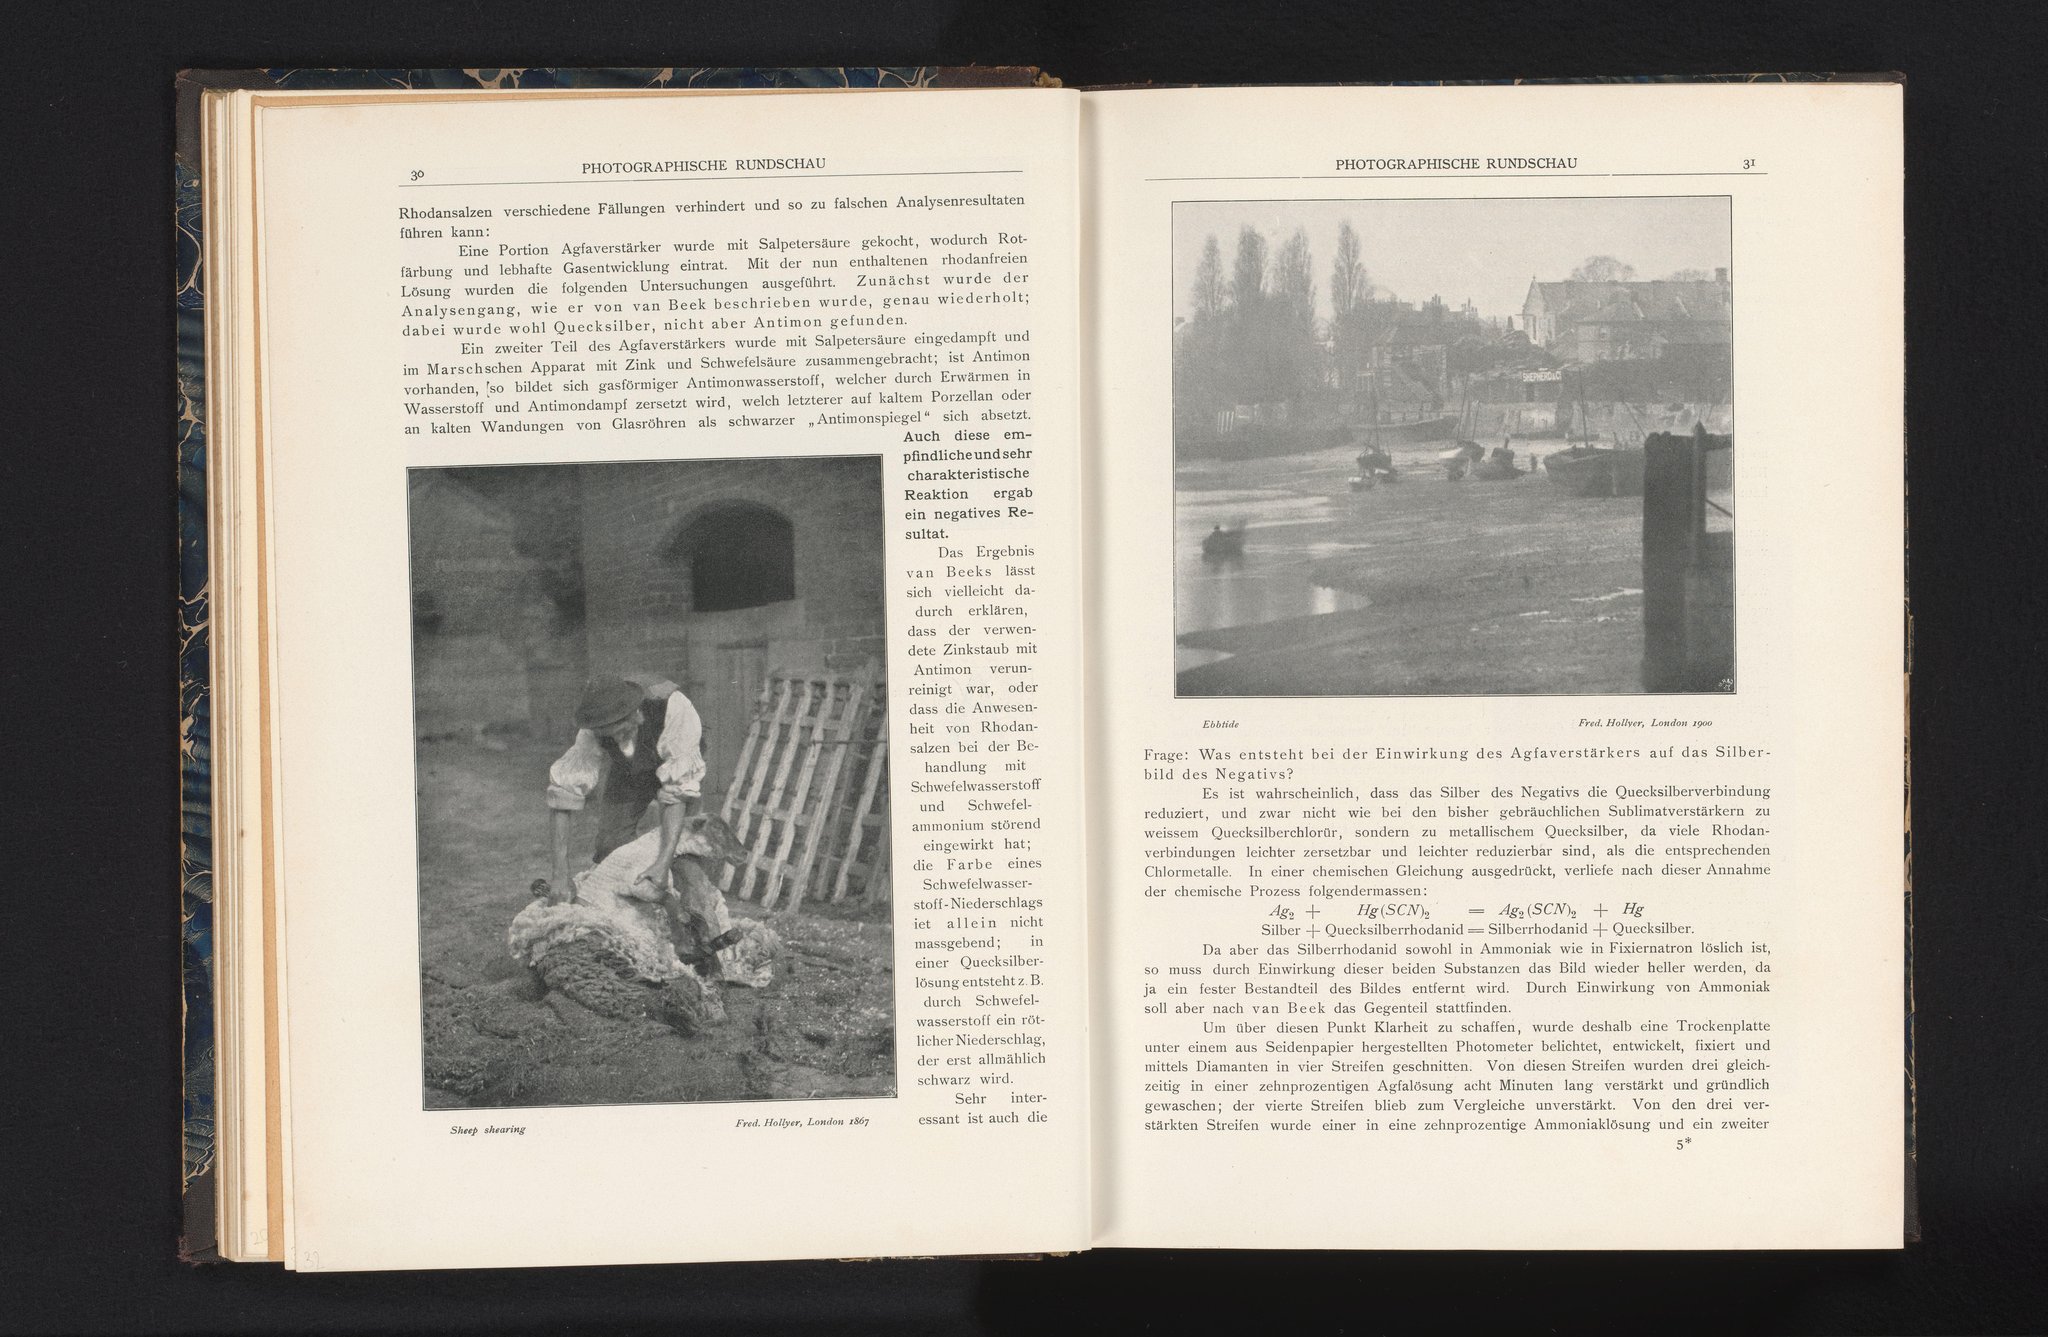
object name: page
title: Ebbtide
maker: frederick hollyer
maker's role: fotograaf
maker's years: 1838-1933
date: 1900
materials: paper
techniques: autotype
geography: berlin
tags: ebb, low tide, river, ships (in general)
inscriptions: inscription: ‘London 1900’, monogram: ‘MR&C’